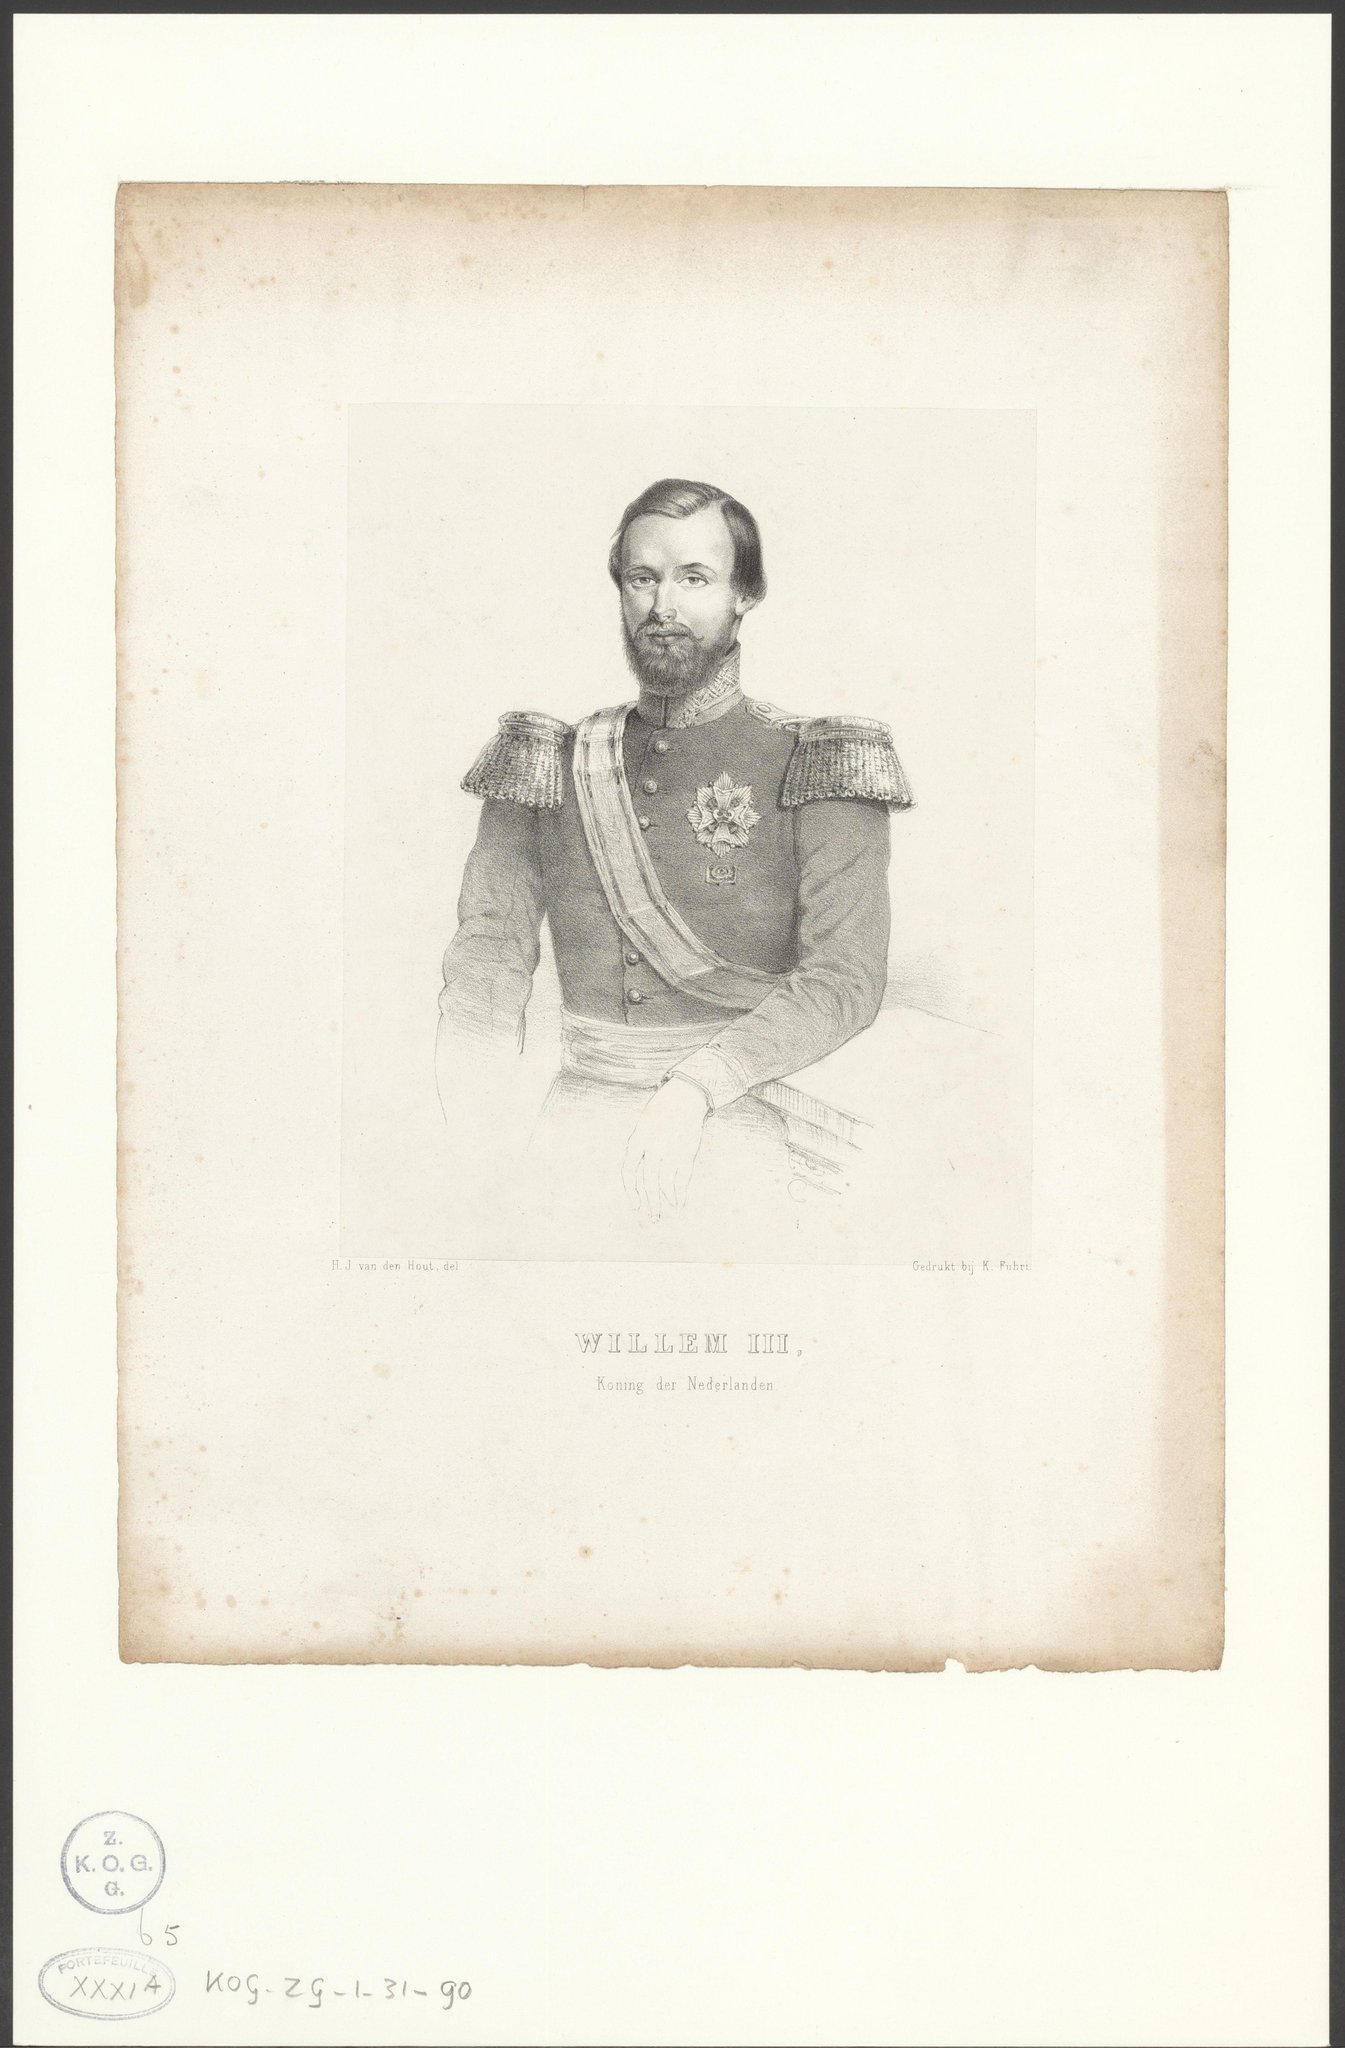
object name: print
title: Portret van Willem III, koning der Nederlanden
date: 1849-1853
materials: paper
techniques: lithograph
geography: the hague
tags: brussels, willem iii (koning der nederlanden), historical persons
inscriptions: collector's mark: Lugt 1641, stamp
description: Onderwerpsrubrieken binnen de Atlas Zeden en Gewoonten: Portretten, Portretten van Vorsten uit het huis van Oranje, Regeerende Vorsten, Koningen uit het huis van Oranje.